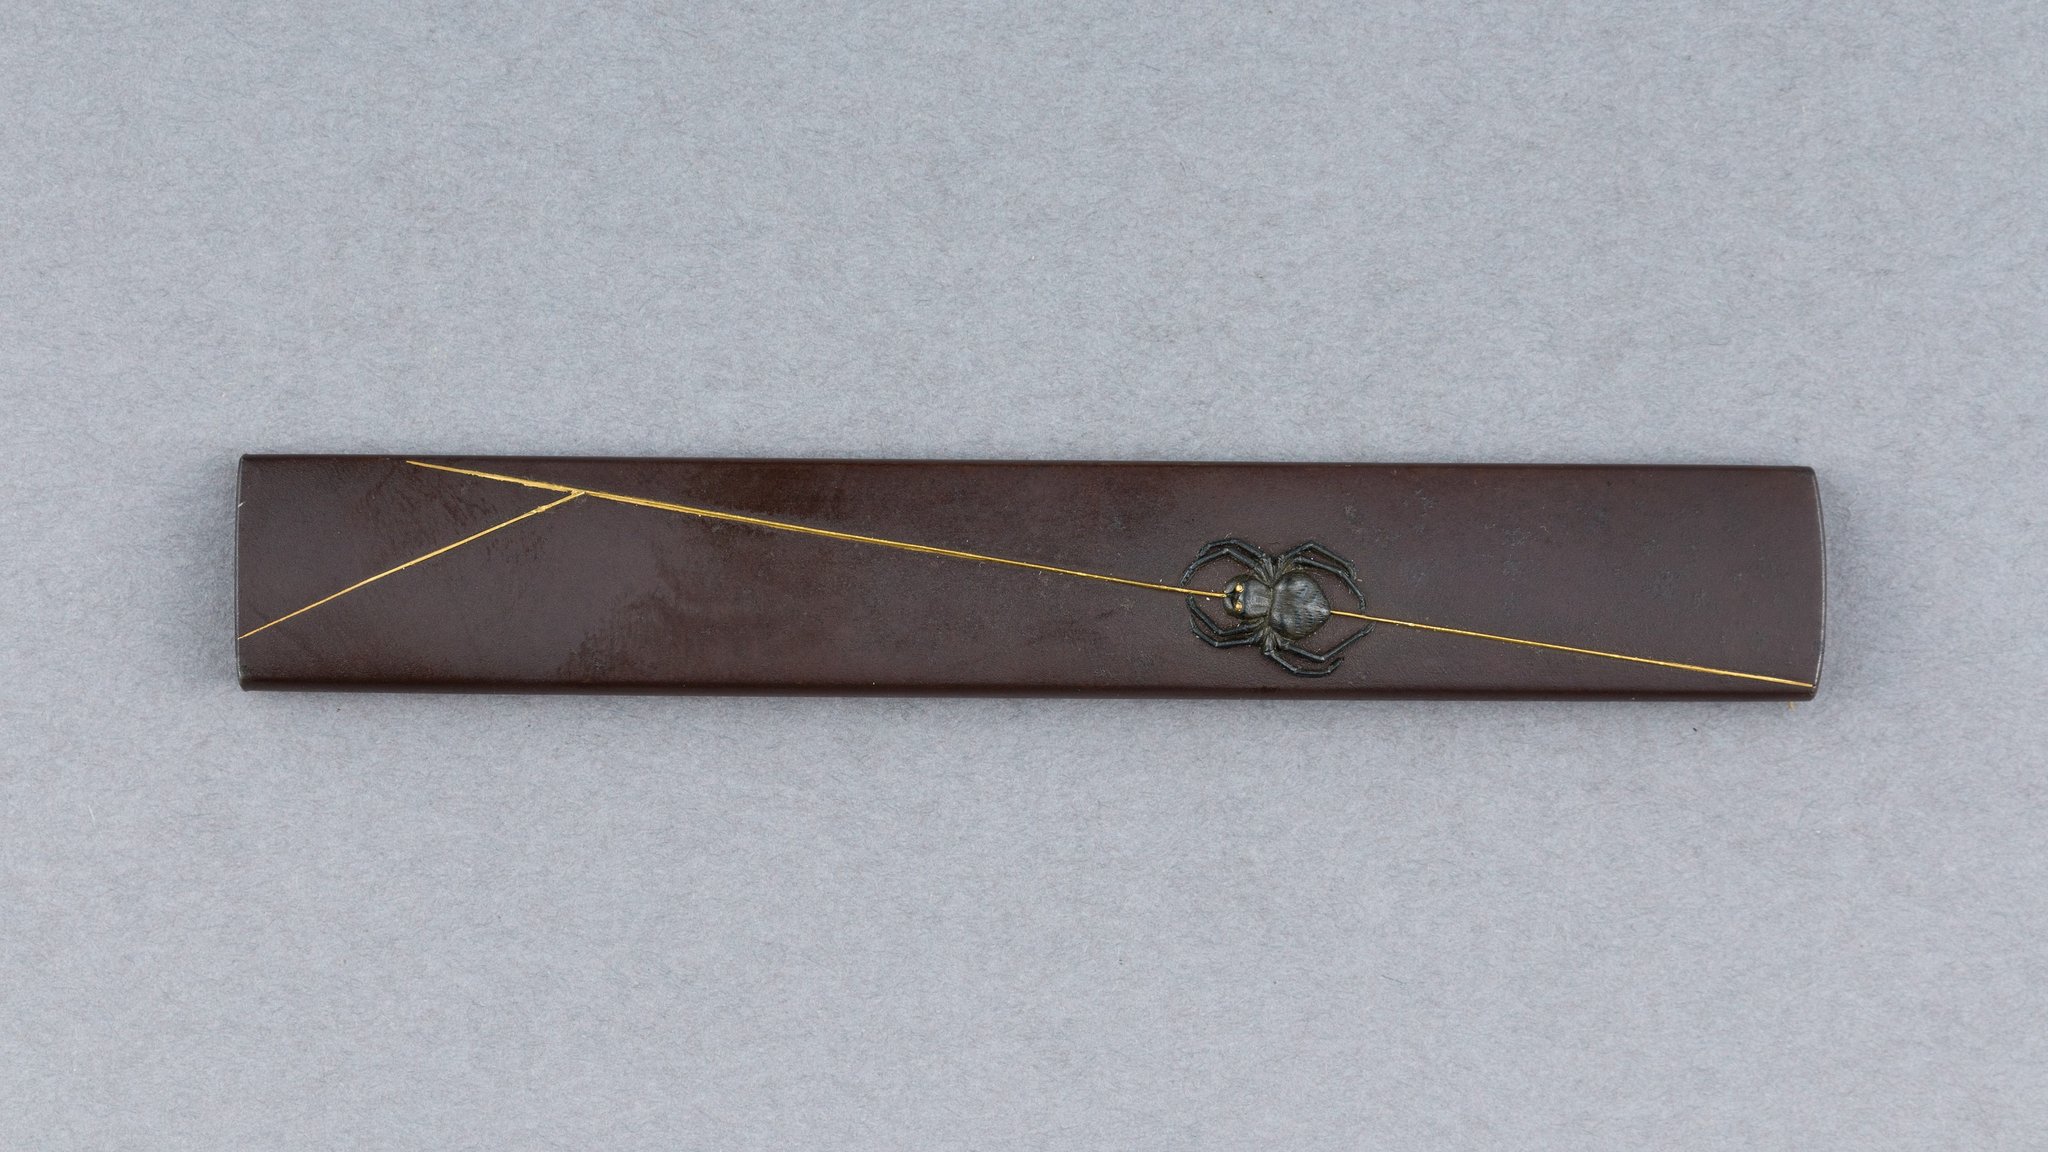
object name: knife handle kozuka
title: Knife Handle (Kozuka)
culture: japanese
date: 1834-1866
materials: silver alloy, gold, iron, silver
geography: japan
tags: spiders